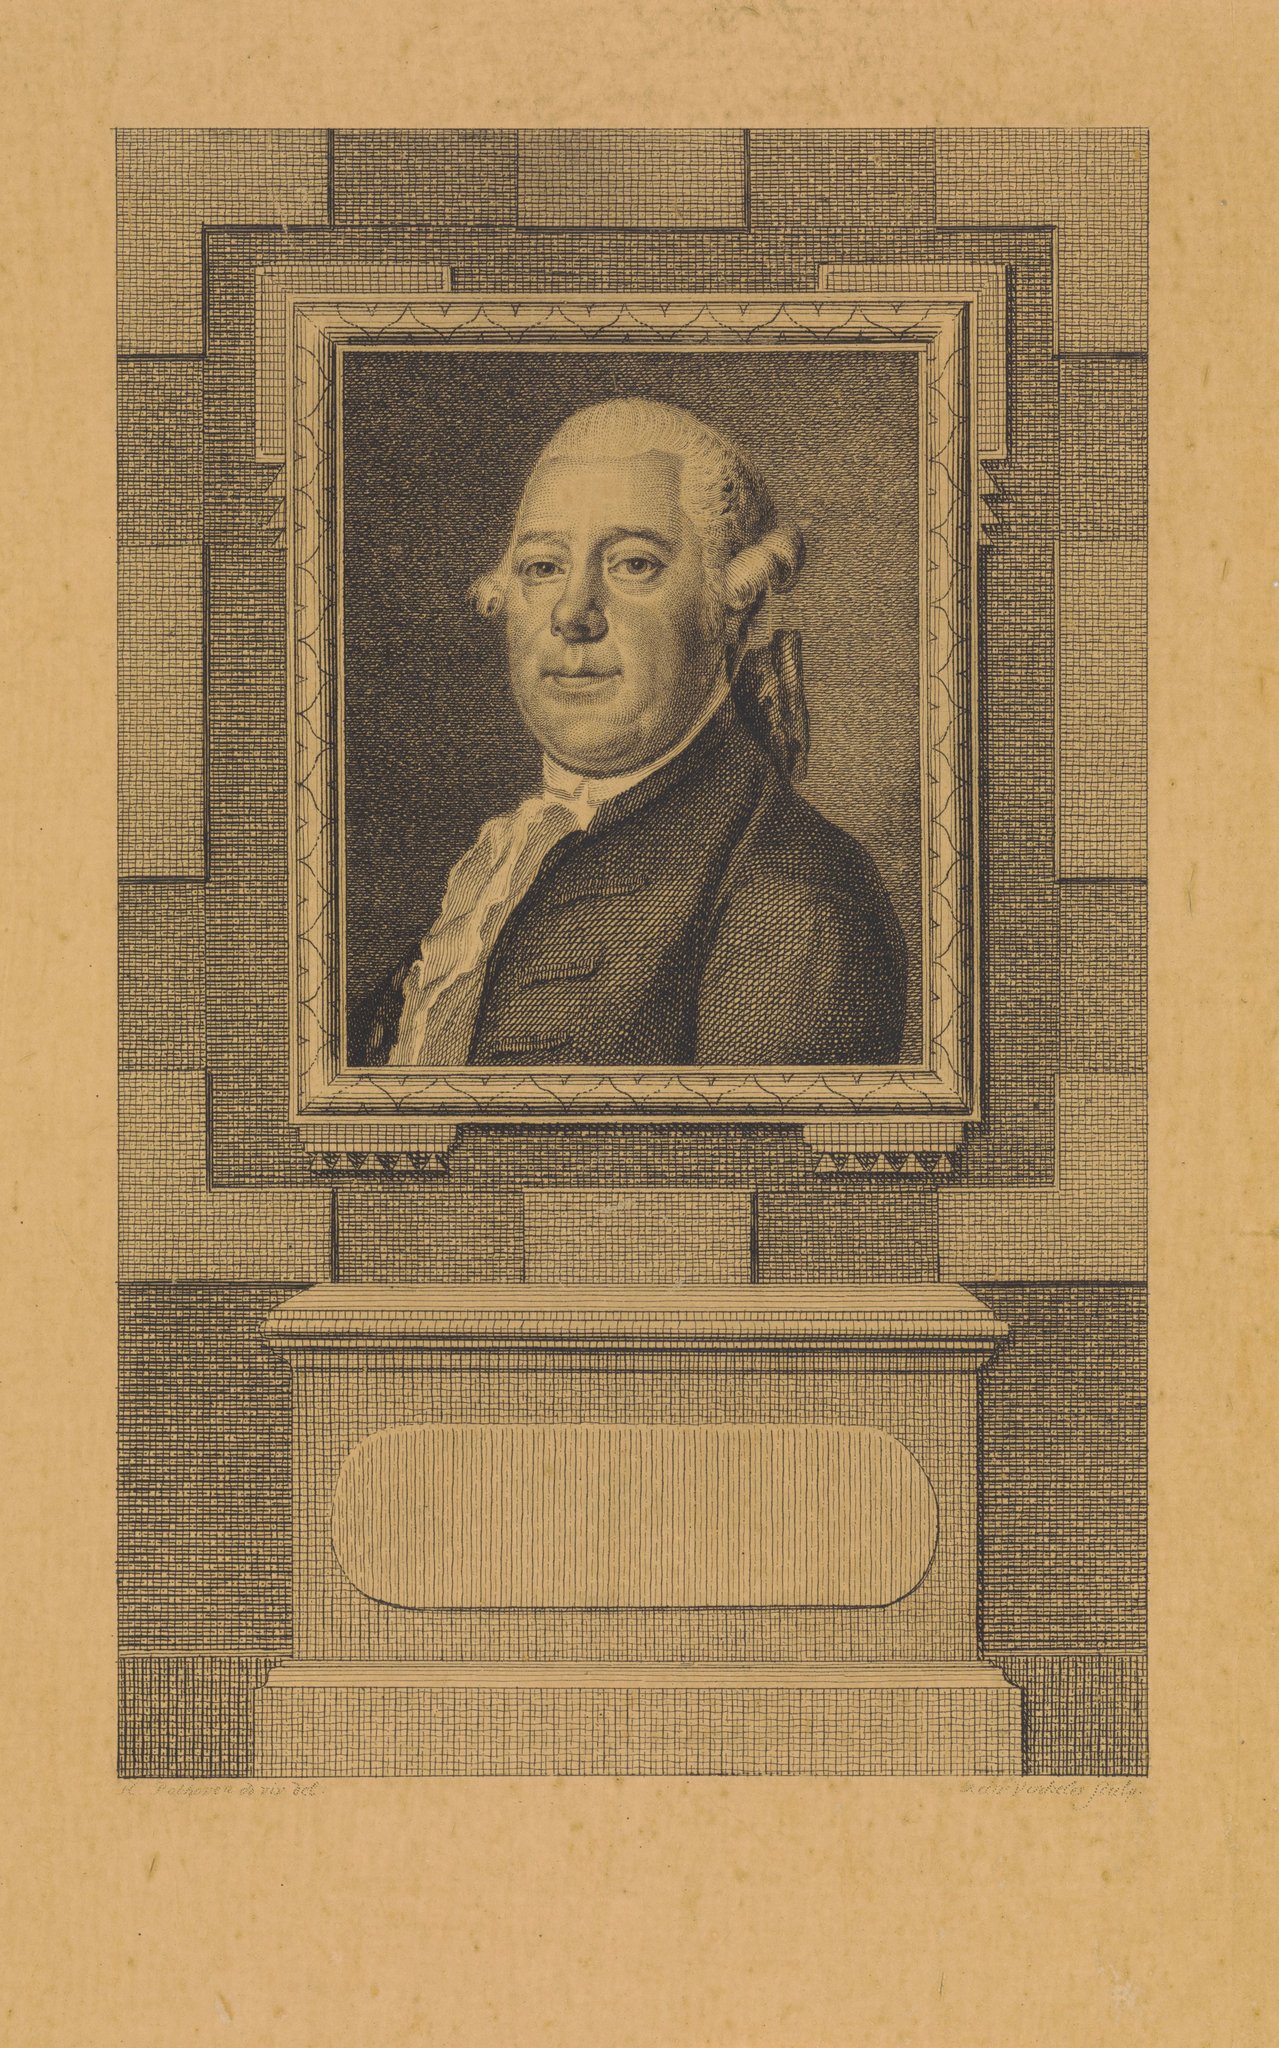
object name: print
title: Portret van Hendrik van Wijn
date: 1791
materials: paper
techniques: engraving, etching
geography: amsterdam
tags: the hague, draughtsman, hendrik van wijn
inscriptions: collector's mark: Lugt 2228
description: Latere staat gebruikt in: Wagenaar, Jan. Vaderlandsche historie, vervattende de geschiedenissen der Vereenigde Nederlanden, (...). Amsterdam: Johannes Allart, 1791, dl. 6.